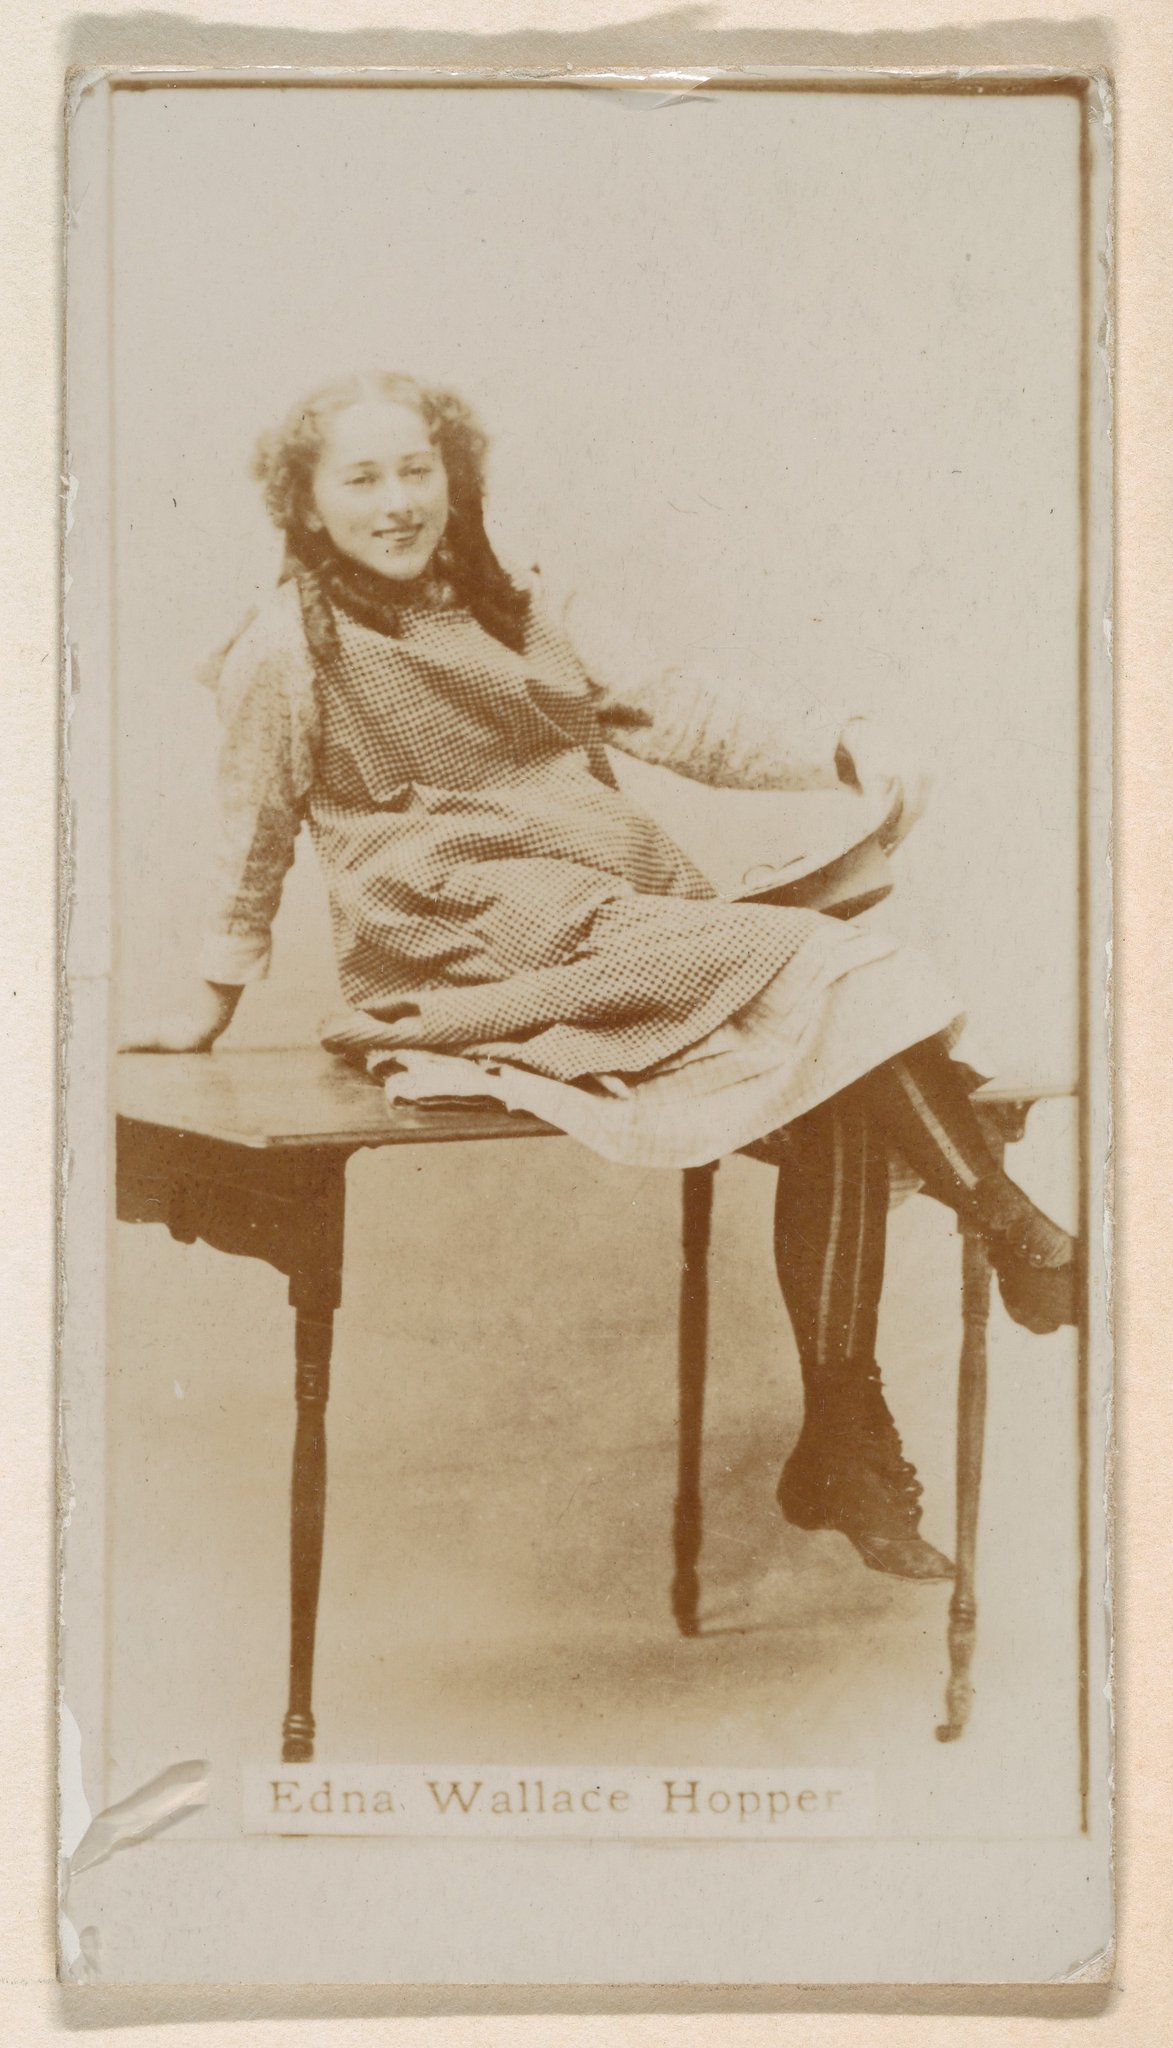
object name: photograph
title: Edna Wallace-Hopper, from the Actresses series (N245) issued by Kinney Brothers to promote Sweet Caporal Cigarettes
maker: kinney brothers tobacco company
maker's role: publisher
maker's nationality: american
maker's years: 1869-2011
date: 1890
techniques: albumen silver print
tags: portraits,women,actresses